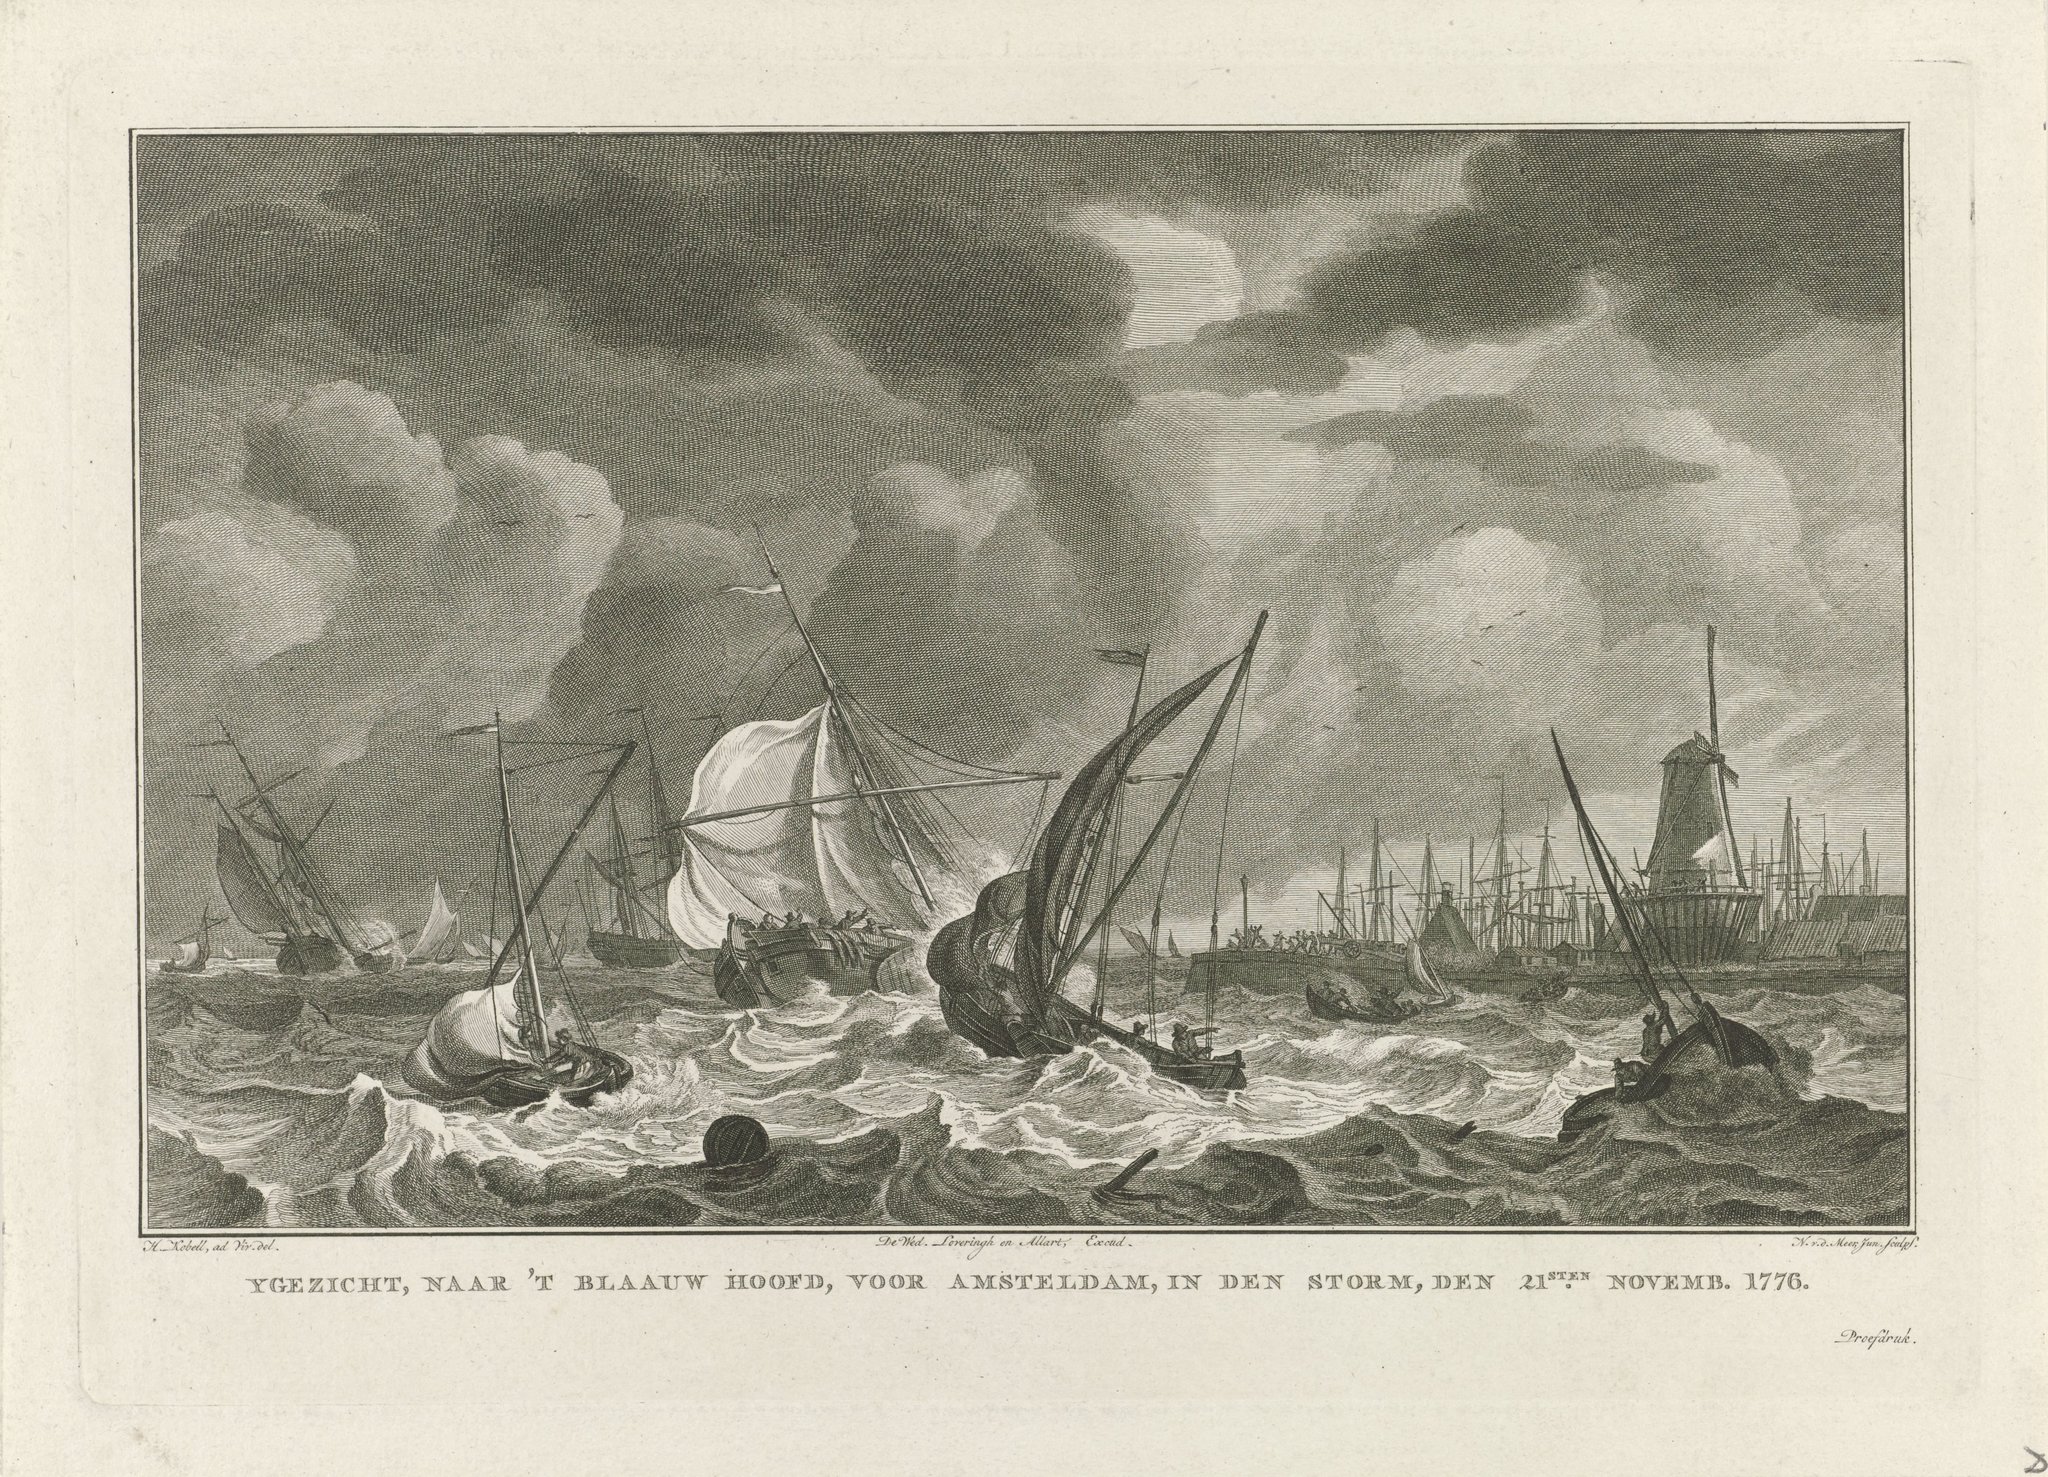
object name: book illustration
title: Storm op het IJ aan het Blauwhoofd van Amsterdam, 1776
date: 1778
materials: paper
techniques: engraving, etching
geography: amsterdam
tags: sailing-ship, sailing-boat, storm at sea, amsterdam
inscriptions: collector's mark: Lugt 2228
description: Prent ook gebruikt in: Hering, Johan Hendrik. Bespiegeling over Neêrlandsch waternood, tusschen den XXIsten en XXIIsten november, MDCCLXXVI. Amsterdam: Johannes Allart, 1778, tussen p. 12 en 13. Zie RP-P-AO-20-85 en RP-P-OB-23.436 voor latere staten.